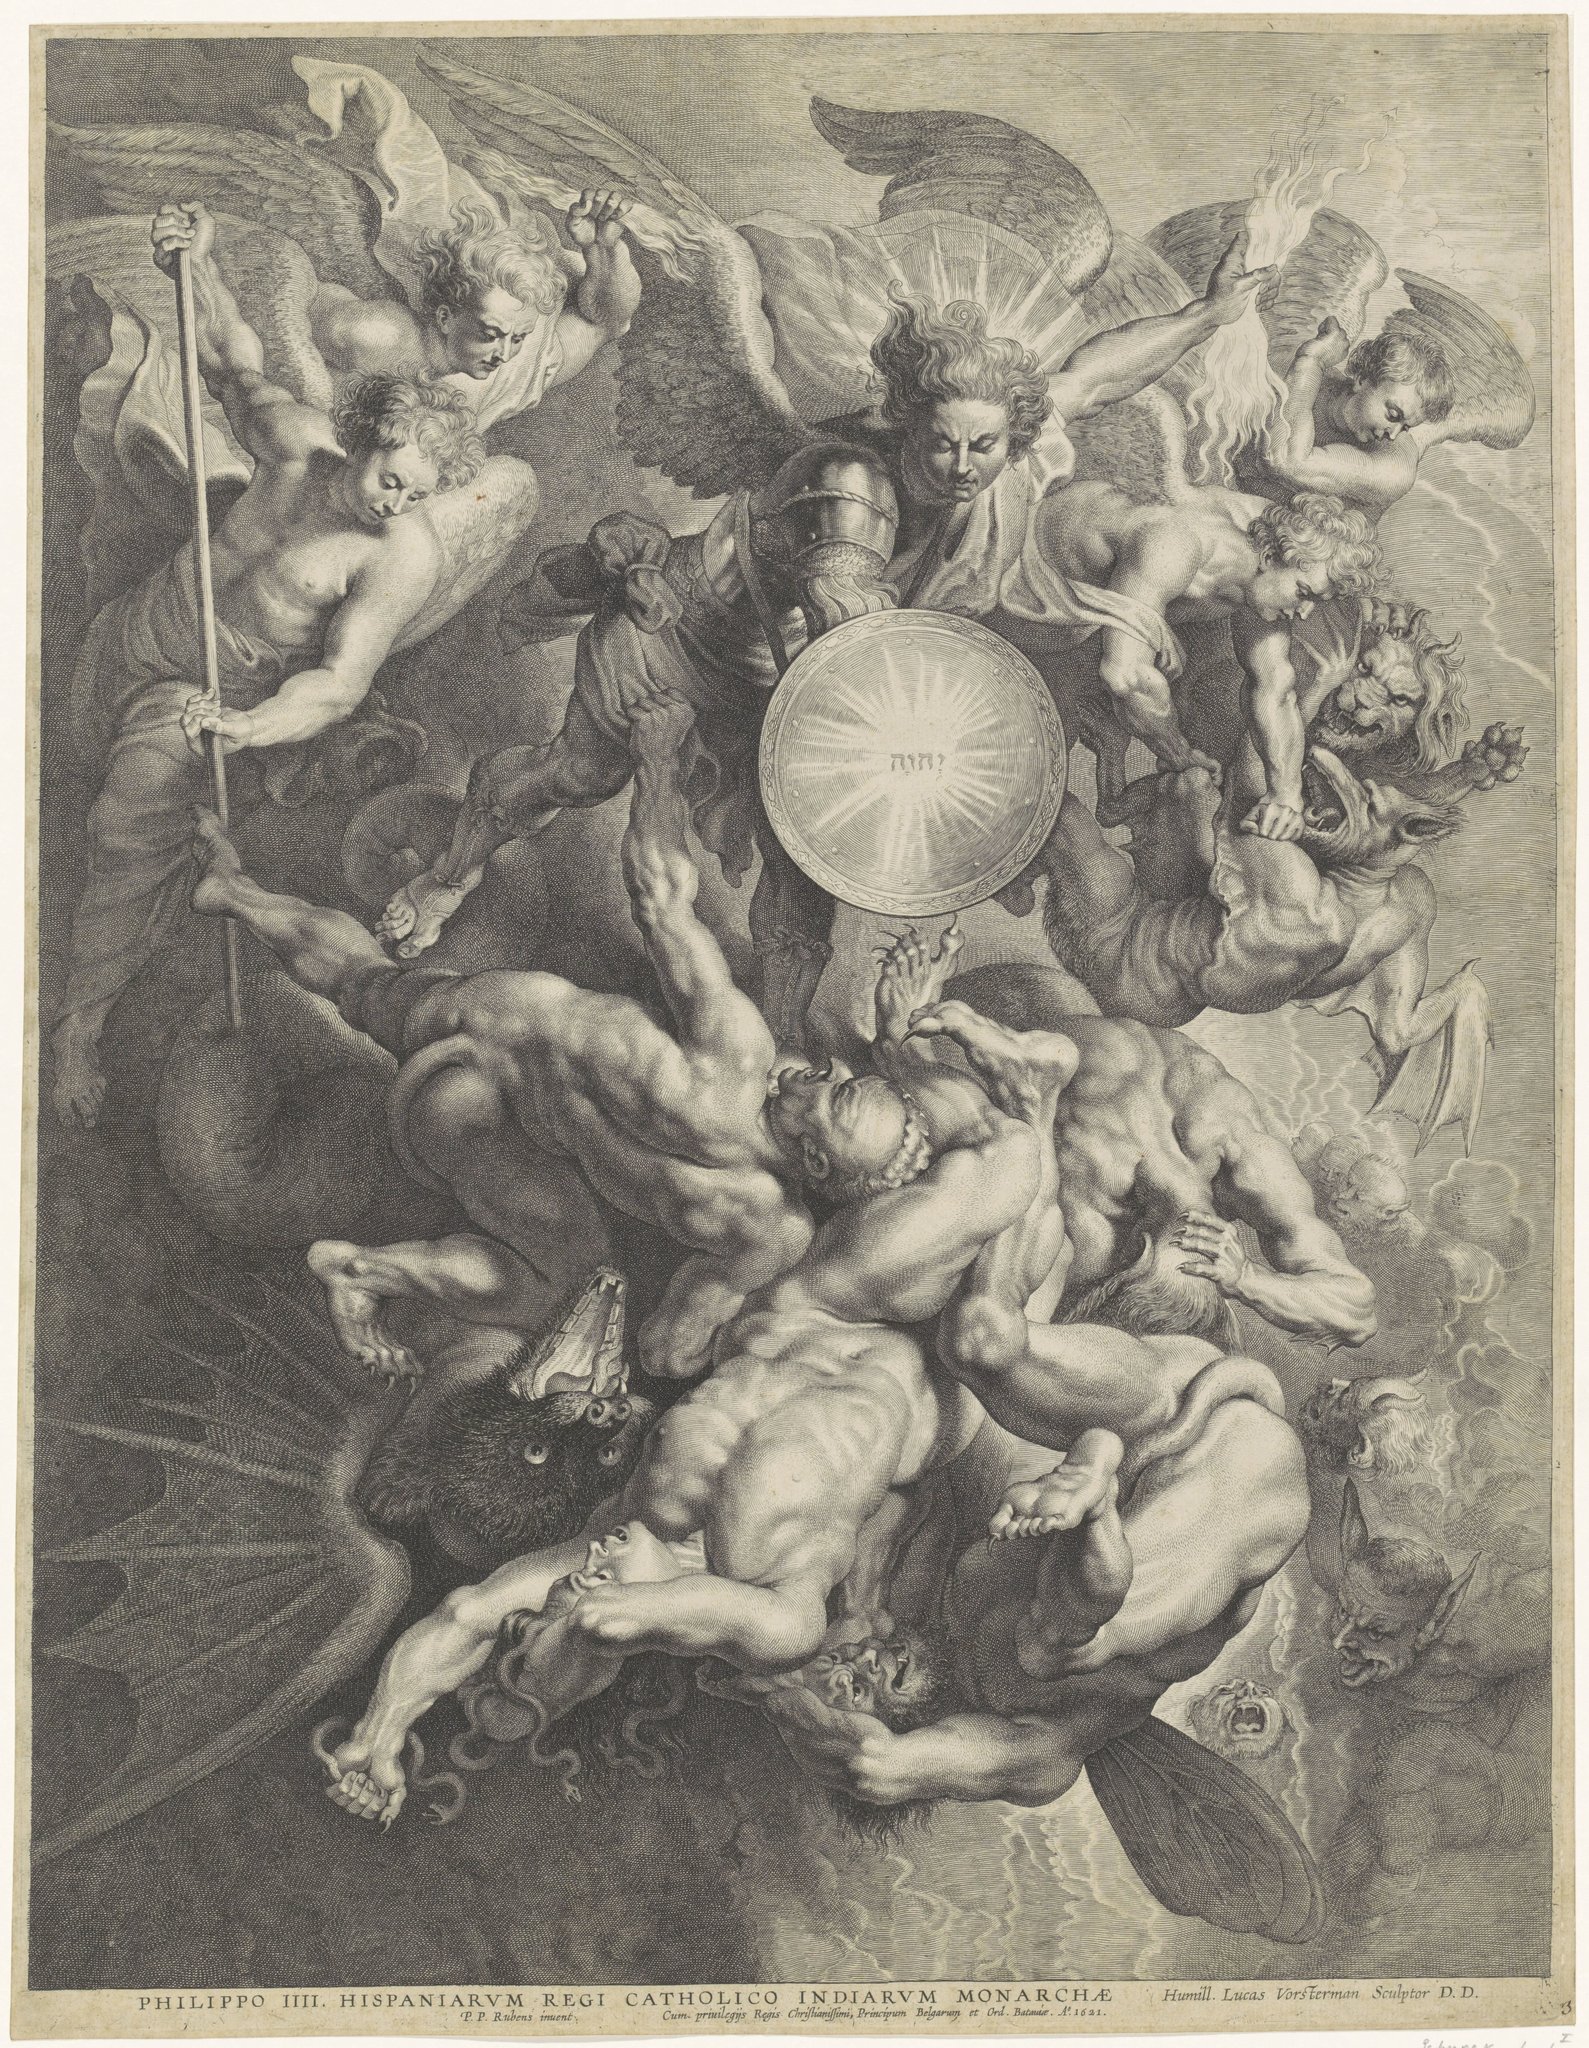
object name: print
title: Michaël en de val van de opstandige engelen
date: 1621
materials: paper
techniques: engraving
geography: antwerp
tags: fall of the rebel angels, who become devils, the archangel michael (and other angels) casting the rebel angels out of heaven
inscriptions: collector's mark: Lugt 10, number: ‘3’, collector's mark: Lugt 11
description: De aartsengel Michaël, in zijn ene hand een schild met het symbool van God de Vader en in zijn andere hand een bliksemschicht, gooit samen met andere engelen de opstandige engelen uit de hemel.